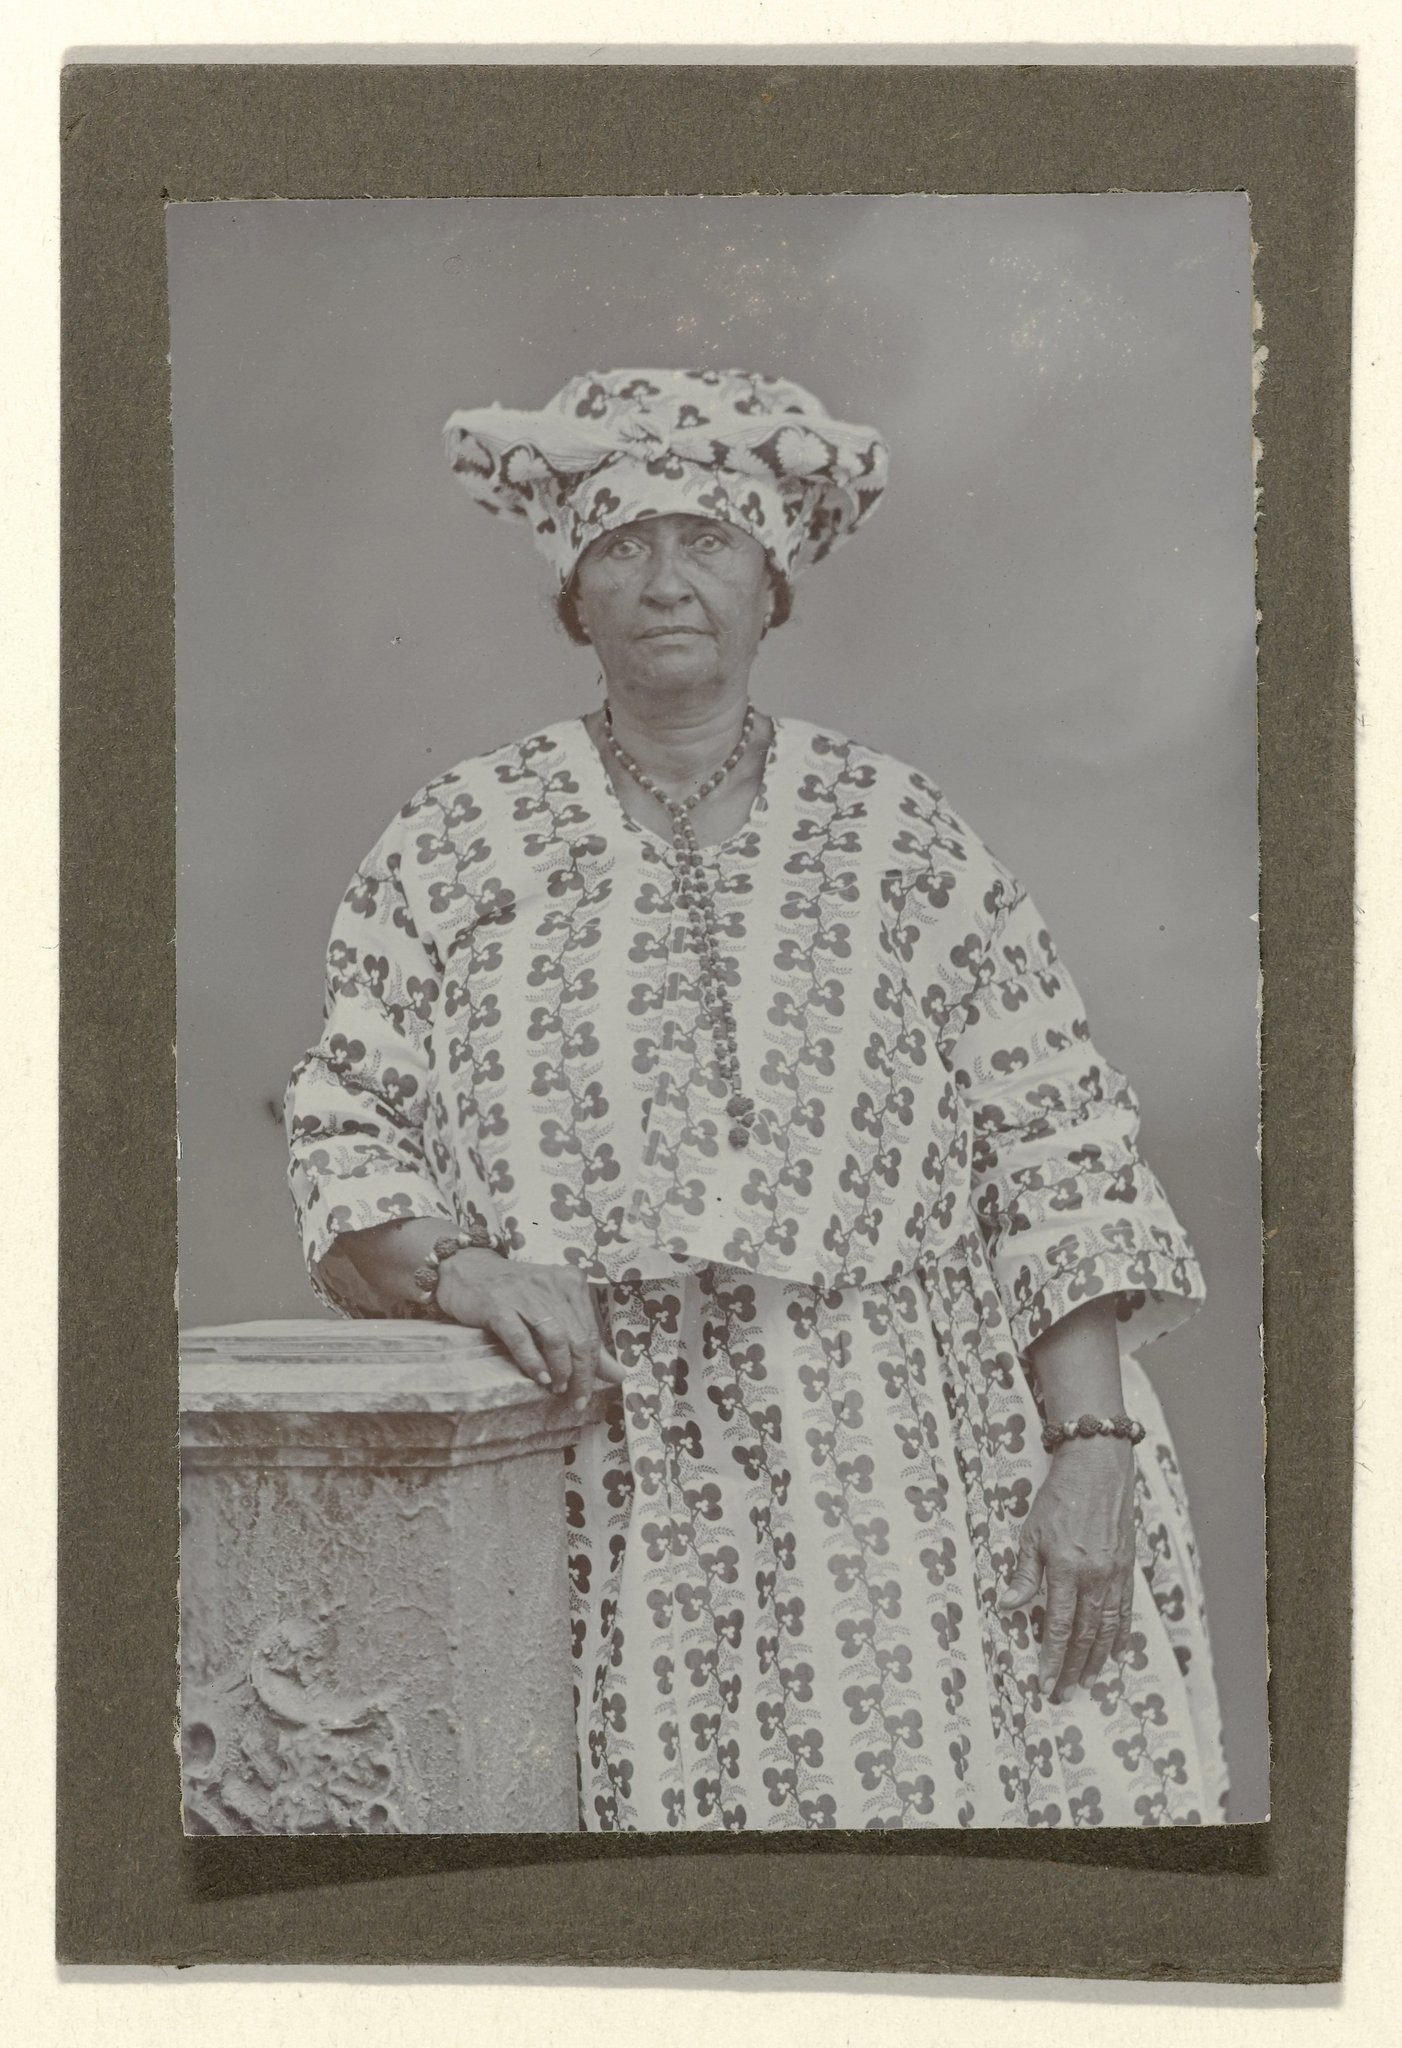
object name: photograph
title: De 'jaja', de kinderjuffrouw van de familie Wesenhagen, de 'nenne'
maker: Anonymous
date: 1900-1920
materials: cardboard, photographic support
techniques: photography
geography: suriname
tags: jacob evert wesenhagen, maid ~ house personnel, suriname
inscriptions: annotation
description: De kinderjuffrouw van de familie Wesenhagen, de 'nenne'. Surinaamse vrouw poseert in koto missie. Onderdeel van een groep objecten afkomstig van de familie Wesenhagen in Suriname.